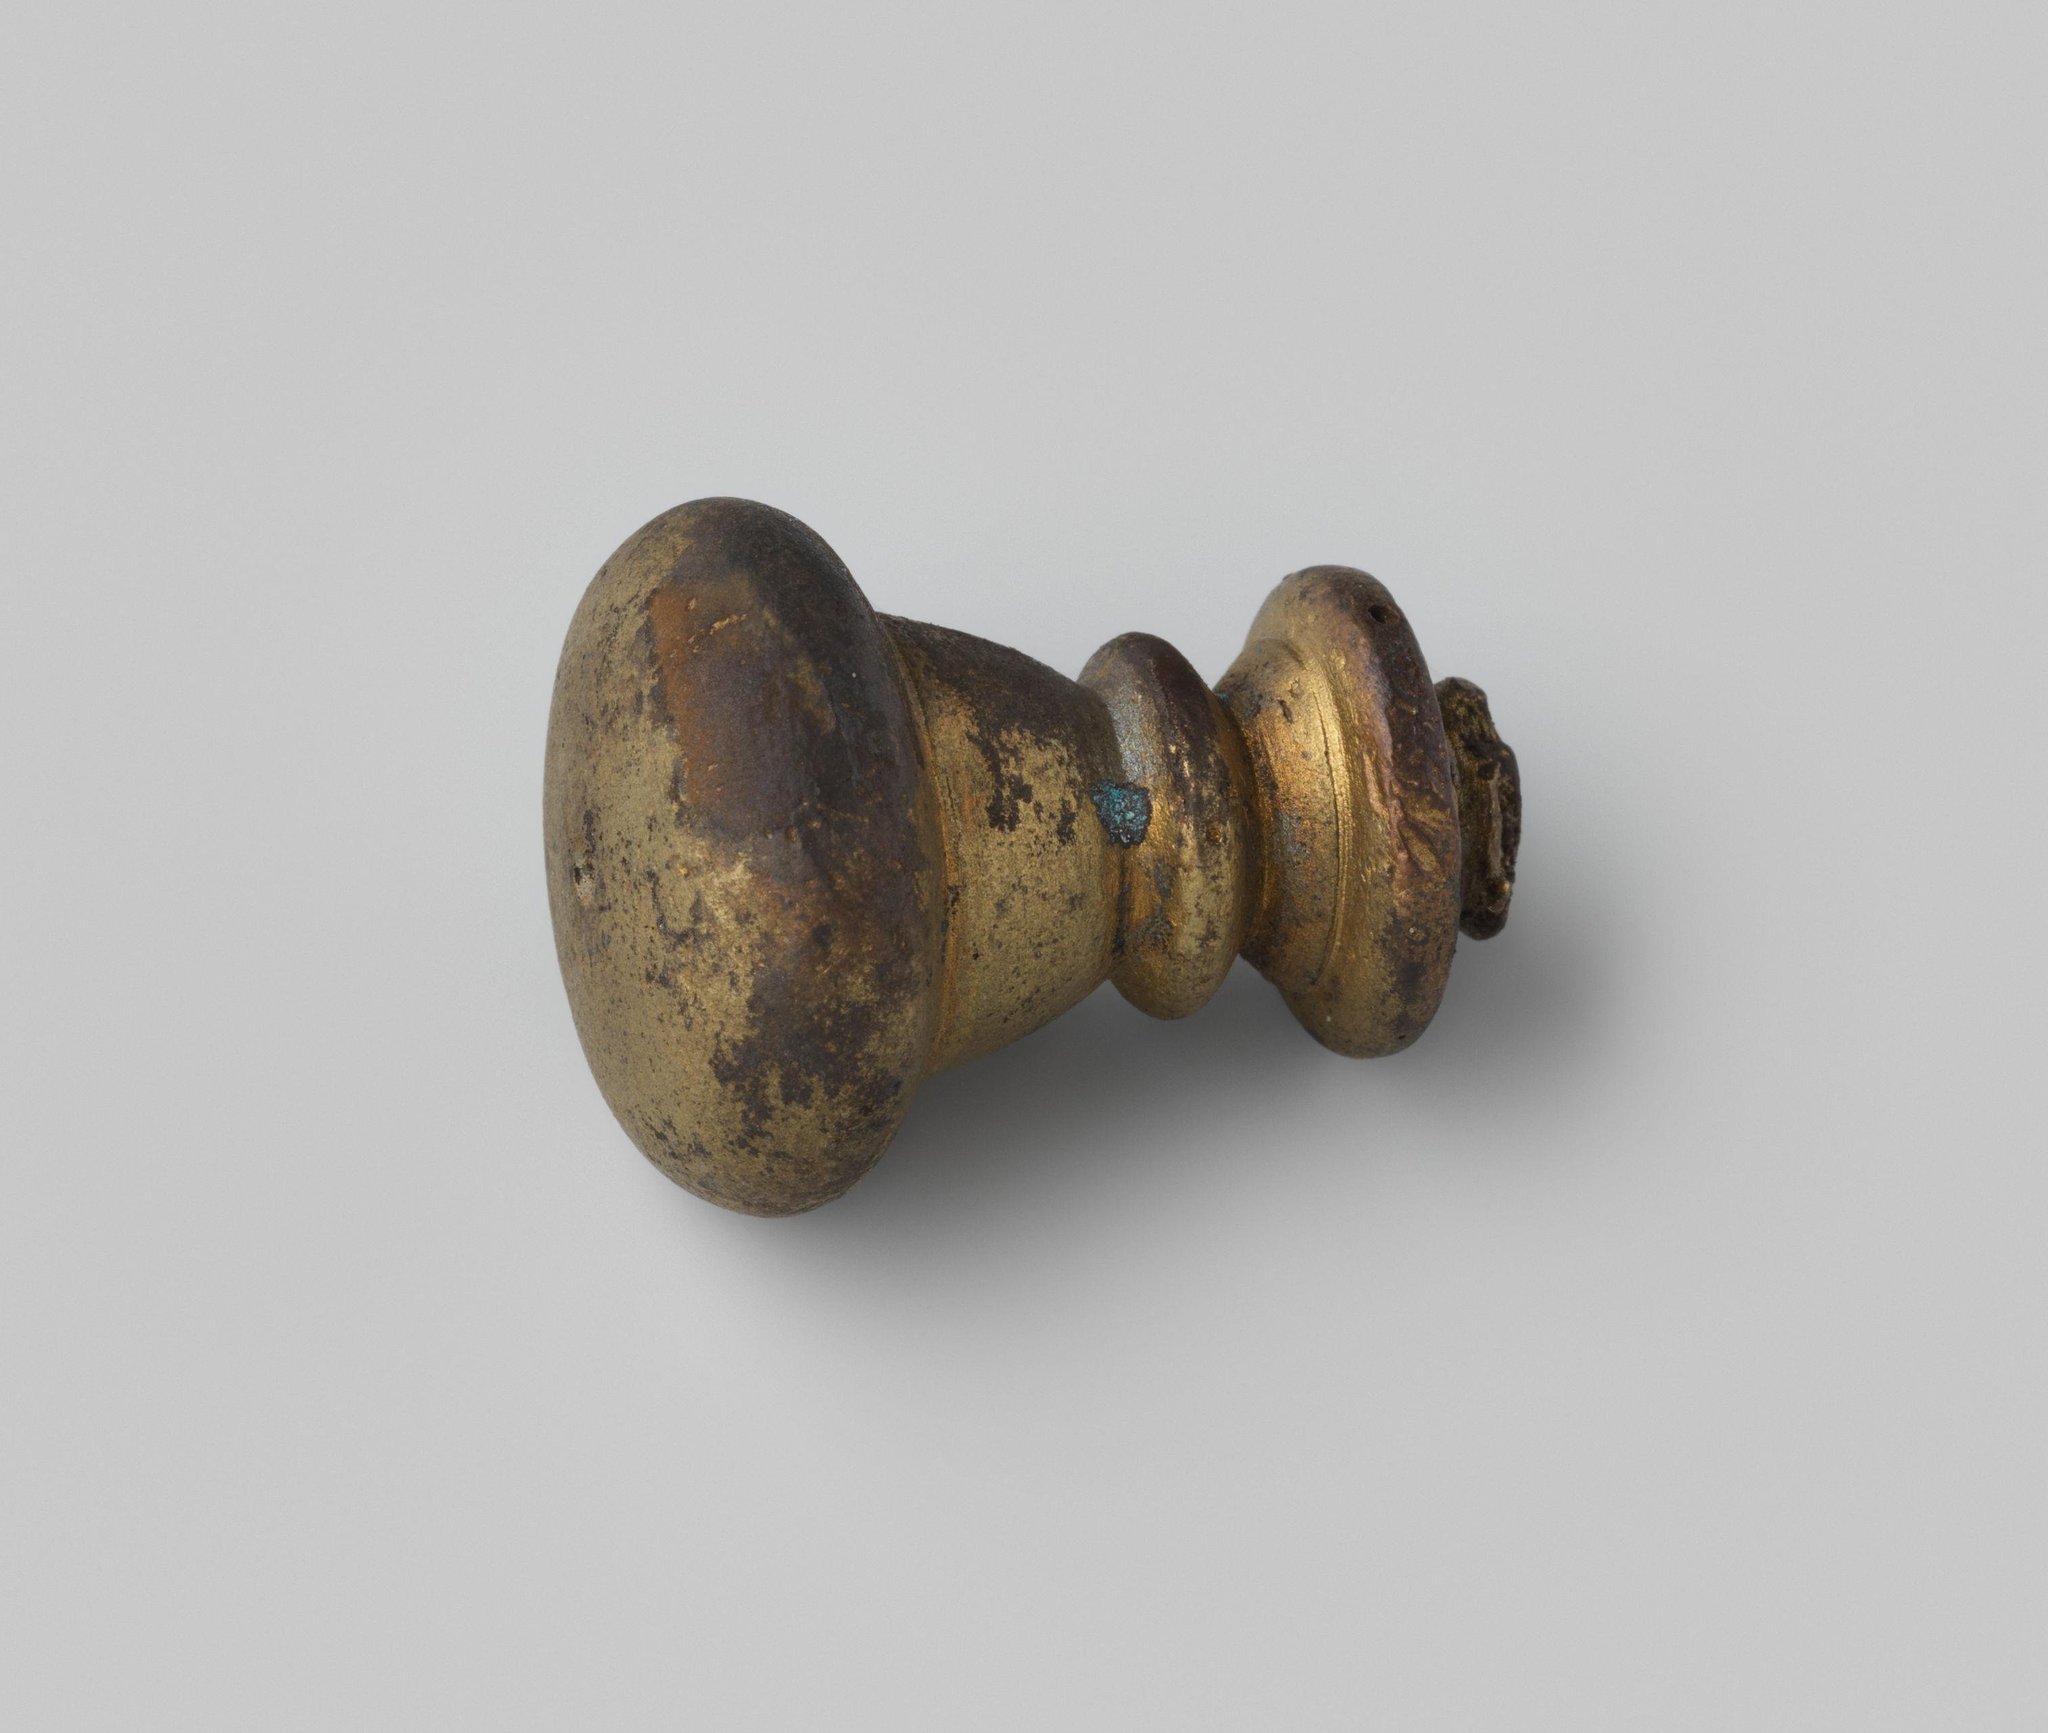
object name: knob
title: Knop uit het wrak van de Oost-Indiëvaarder Hollandia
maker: Anonymous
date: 1700-1743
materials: copper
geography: netherlands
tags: verenigde oostindische compagnie, hollandia (schip), annet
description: Fitting, knob; acorn-shaped with an angular knop, slightly conical stepped base, flattened tenon.